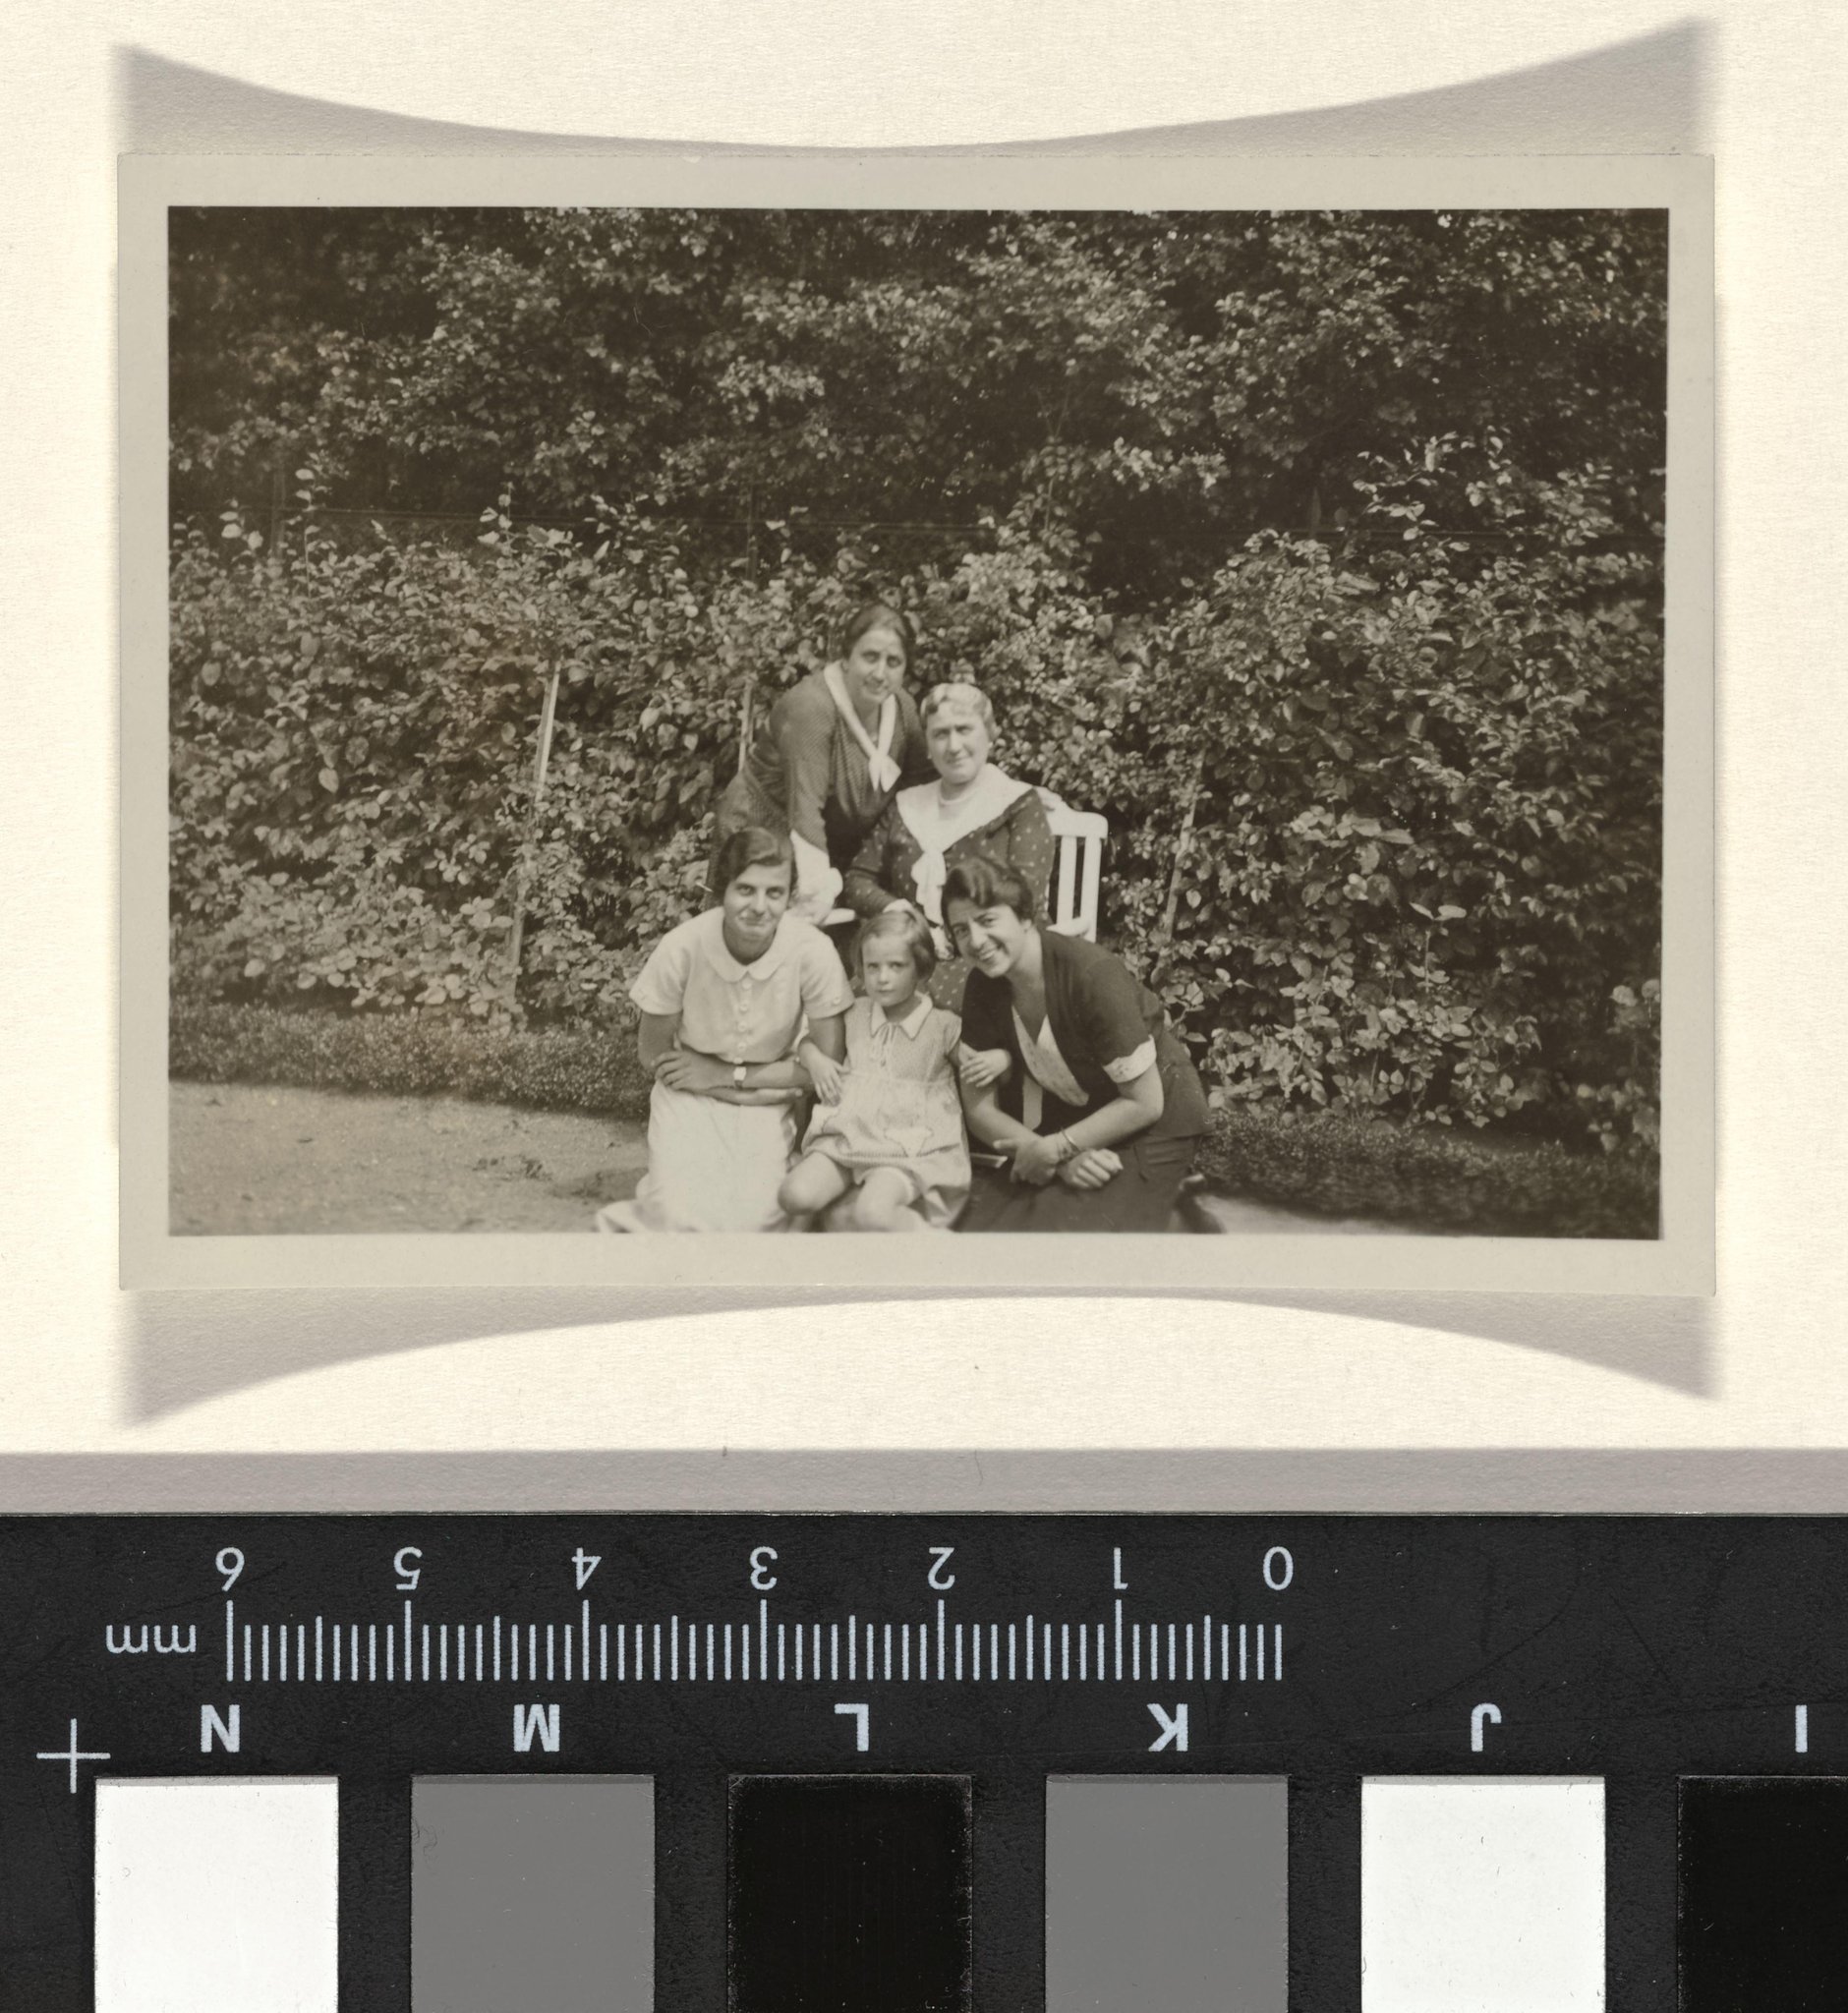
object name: photograph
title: Else Wachenheimer, Josefine Moos-Levi, lid van de huishoudelijke staf, Isabel Wachenheimer en een vrouw in Hamburg, 1933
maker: Anonymous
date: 1933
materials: photographic support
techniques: gelatin silver print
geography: hamburg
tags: else wachenheimer-moos, leiden, isabel wachenheimer-elon, josefine moos-levi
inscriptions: date: ‘Hambg., Aug.33.15’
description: Dit object is onderdeel van de nalatenschap van Isabel Elon-Wachenheimer (1928-2010). Tot haar overlijden behoorde het samen met de andere objecten uit de nalatenschap tot haar privédomein van Isabel Wachenheimer. In die particuliere context zijn deze objecten tezamen en individueel aandenkens - aan de jeugd, ouders en familie van Isabel Wachenheimer vóór en tijdens de Shoah en aan haar leven na de Tweede Wereldoorlog. Isabel Wachenheimer, die van juni 1943 tot mei 1945 gevangen zat in Kamp Westerbork, Theresienstadt, Auschwitz, Lenzing a/d Oberdonau (een buitenkamp van Mauthausen), overleefde de Shoah. Haar ouders – Eugène Wachenheimer en Else Wachenheimer-Moos - werden op 14 oktober 1944 in Auschwitz-Birkenau vermoord.